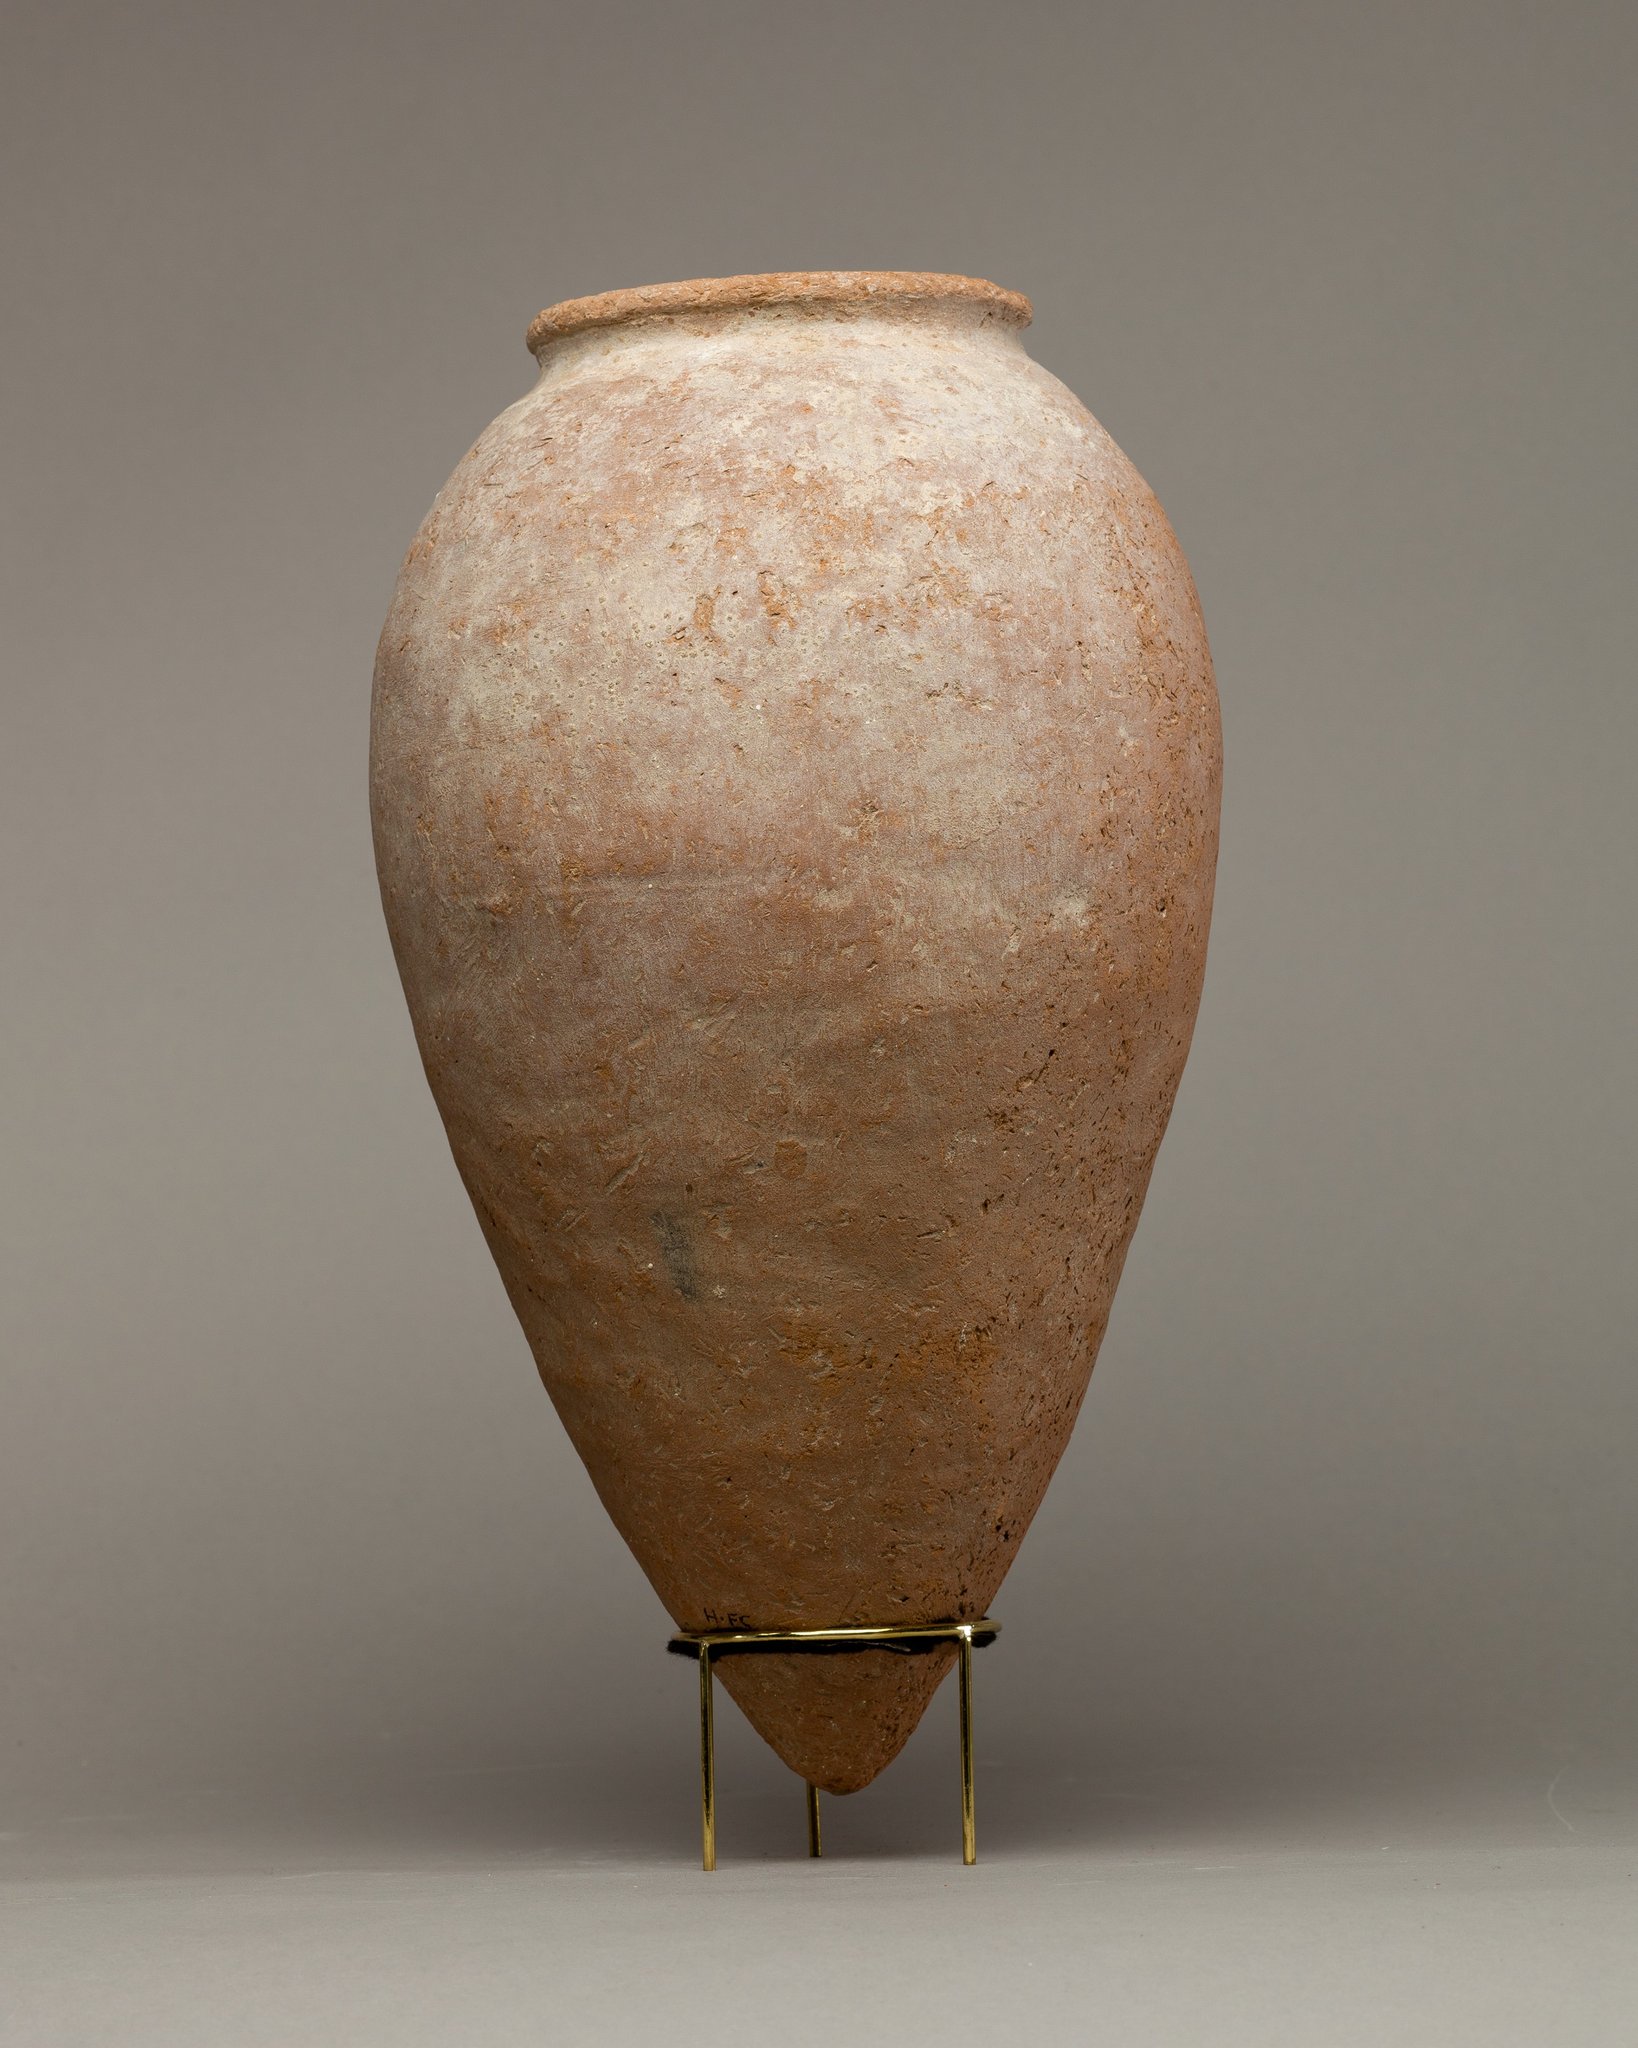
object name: jar, pointed base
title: Jar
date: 3850-2960 BCE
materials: pottery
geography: egypt